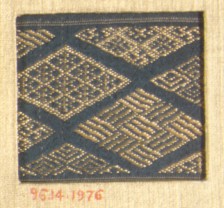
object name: piece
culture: japanese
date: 1701-1900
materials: silk